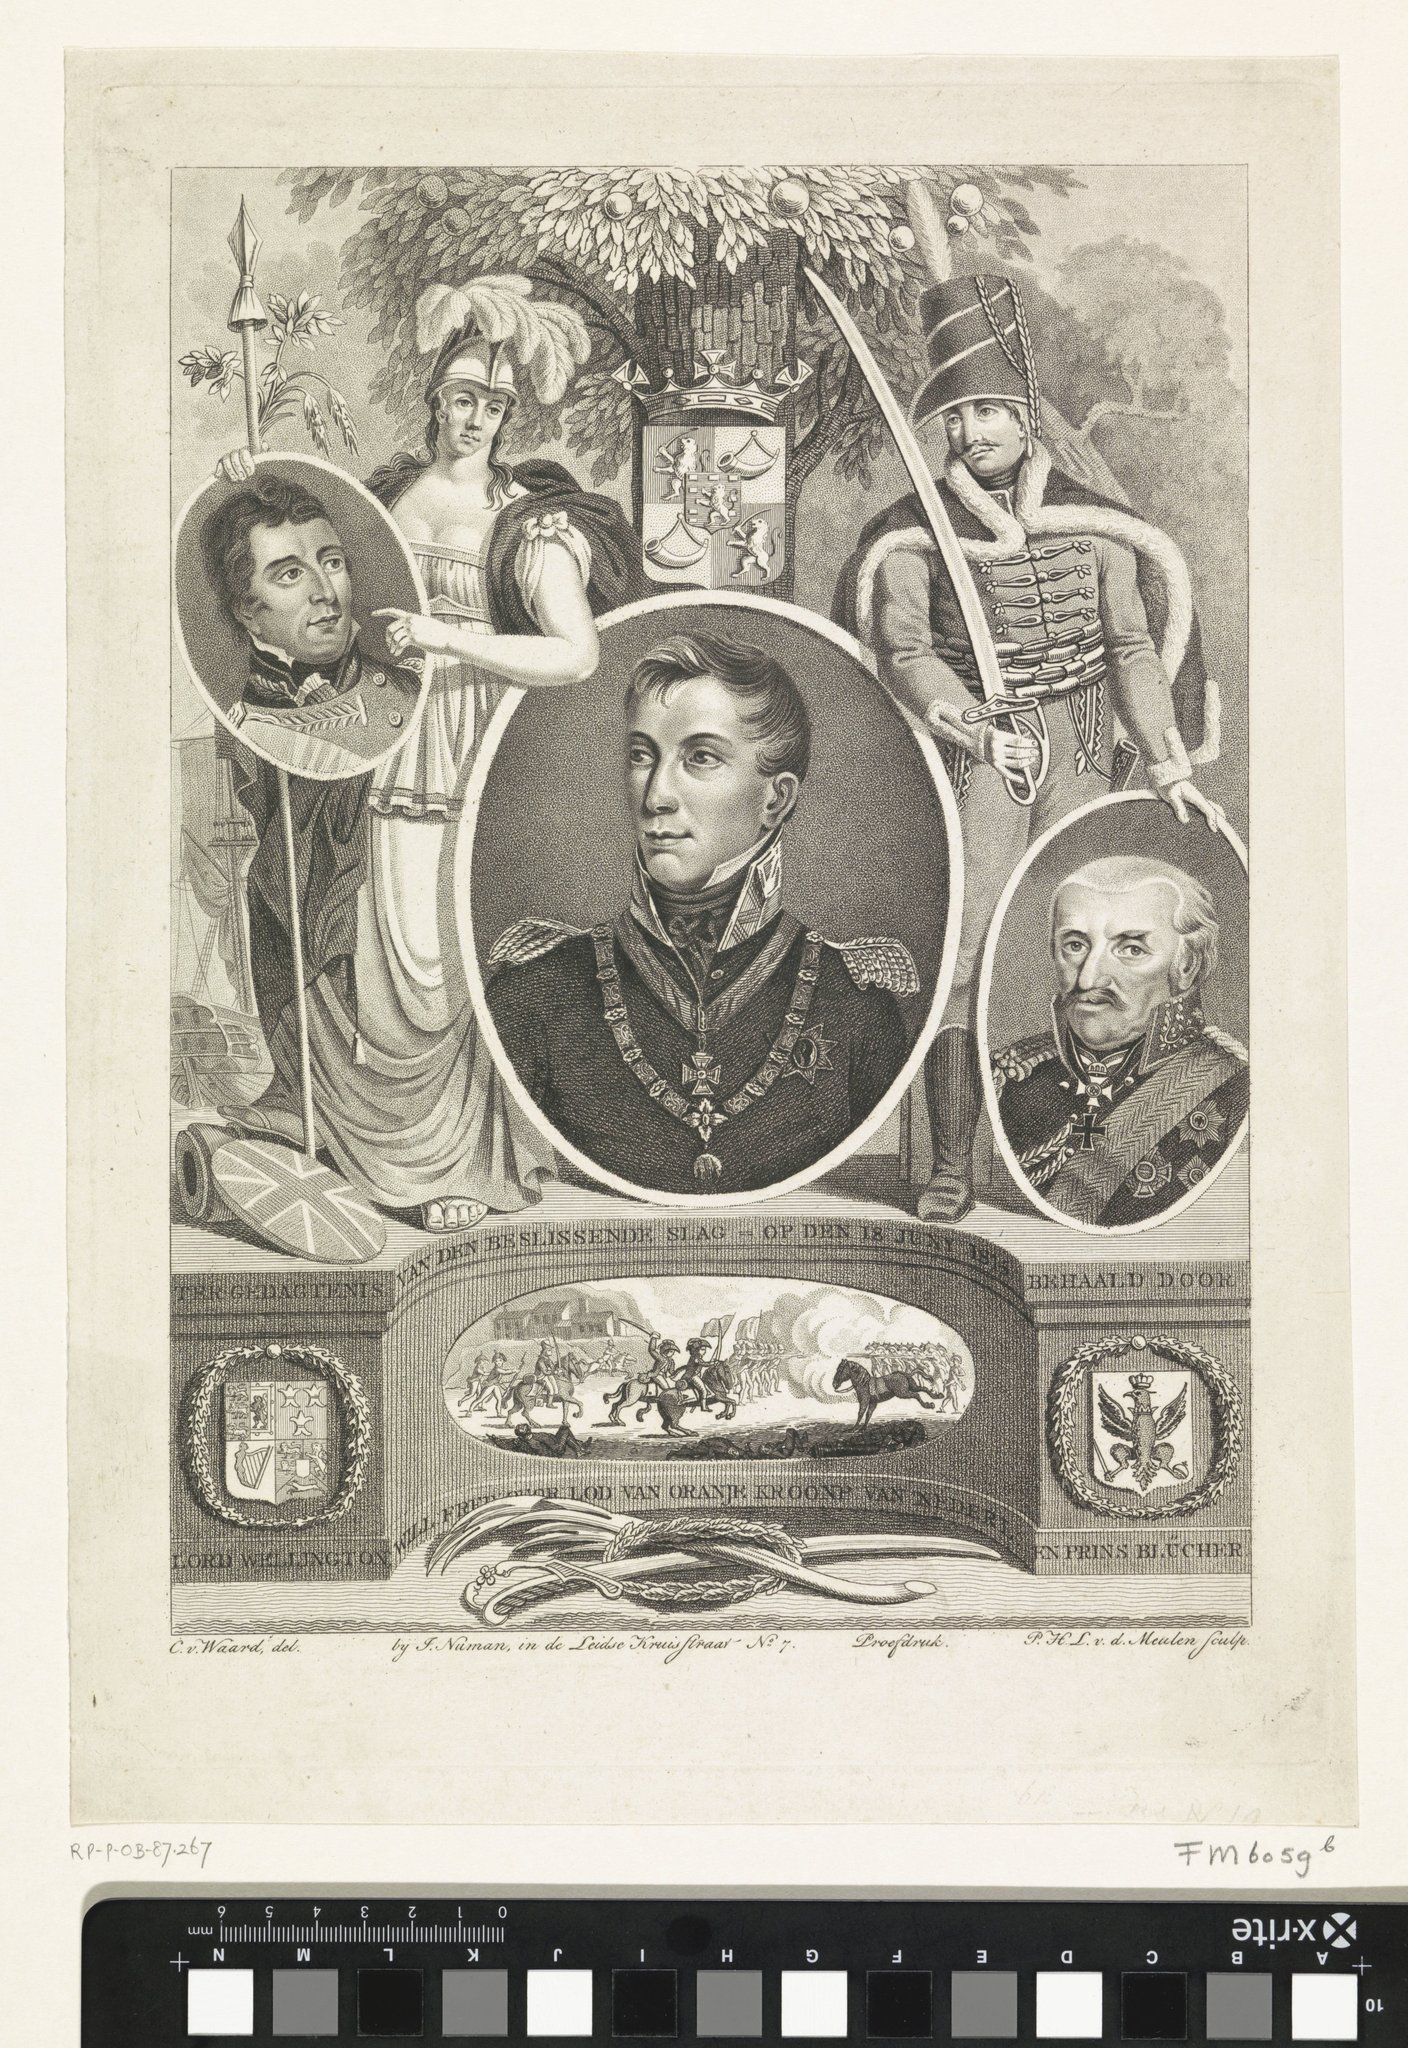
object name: print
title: Allegorie op de helden van de slag bij Waterloo, 1815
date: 1815-1820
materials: paper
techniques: etching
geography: amsterdam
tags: the hague, william ii of the netherlands, walmer castle, arthur wellesley of wellington, battle (+ land forces), waterloo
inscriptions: collector's mark: Lugt 2228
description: Allegorie met een monument op de overwinning van de bondgenoten in de Slag bij Waterloo op 18 juni 1815. Centraal een groot medaillon met het portret van de prins van Oranje, links de Britse Maagd met portret van Wellington, rechts een Pruisische huzaar met het portret van Blücher. Op hetmonument een voorstelling van de veldslag. Achter de prins van Oranje een Oranjeboom en het koninklijke wapen.